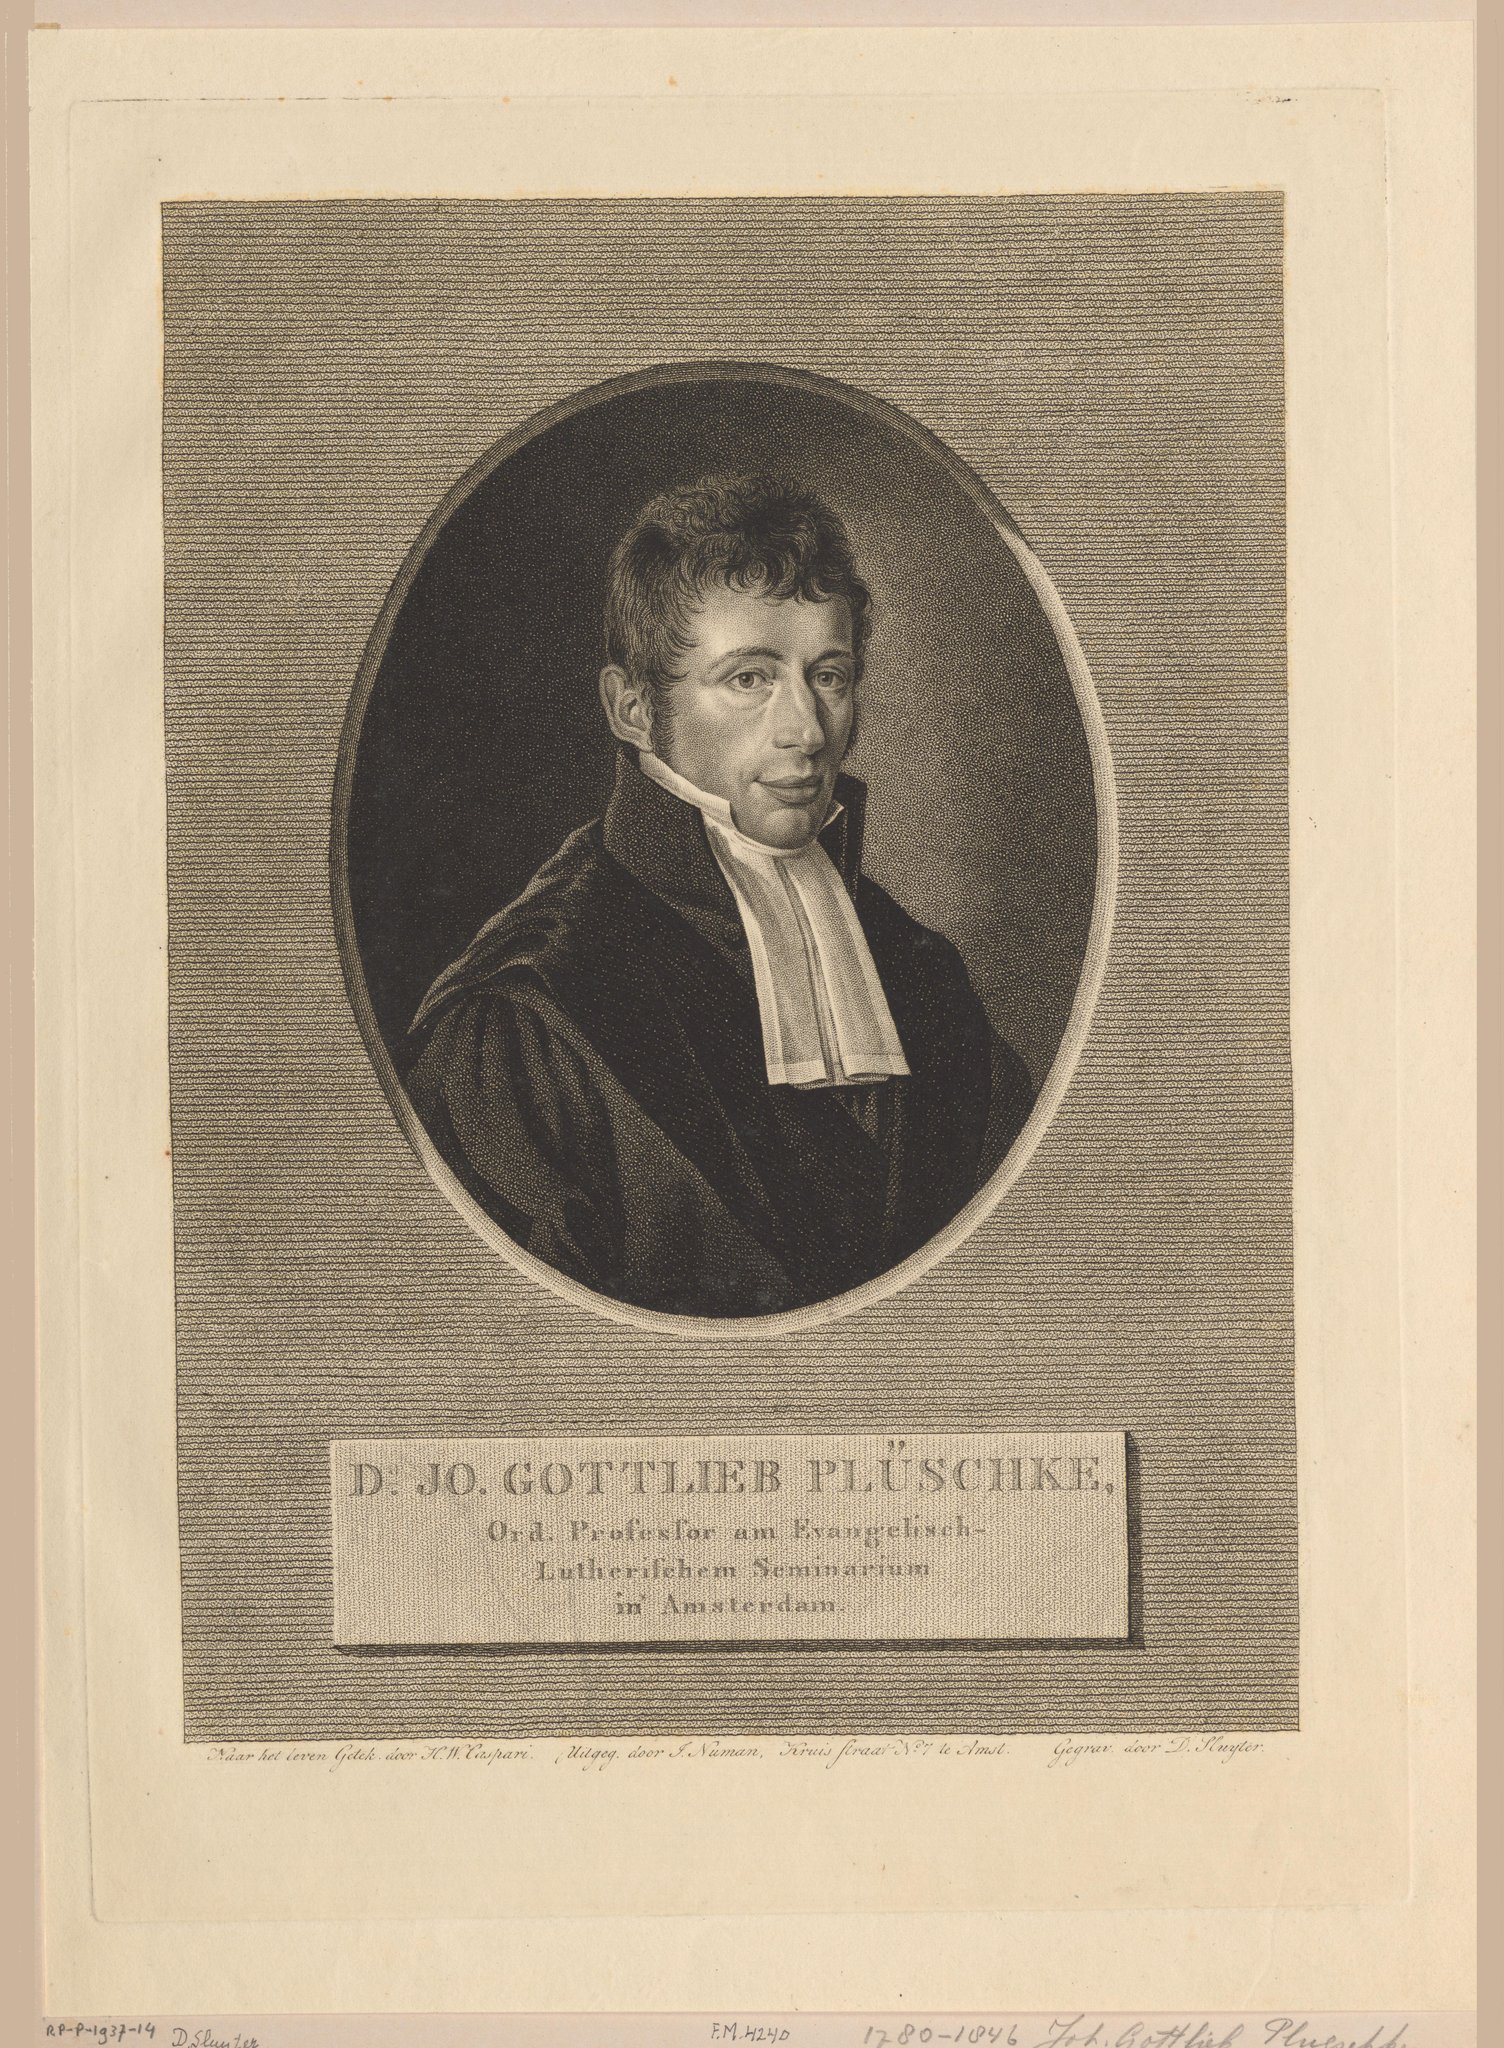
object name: print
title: Portret van Johann Gottlieb Plüschke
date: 1812-1823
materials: paper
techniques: engraving, etching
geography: amsterdam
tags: amsterdam, theologian, historical persons